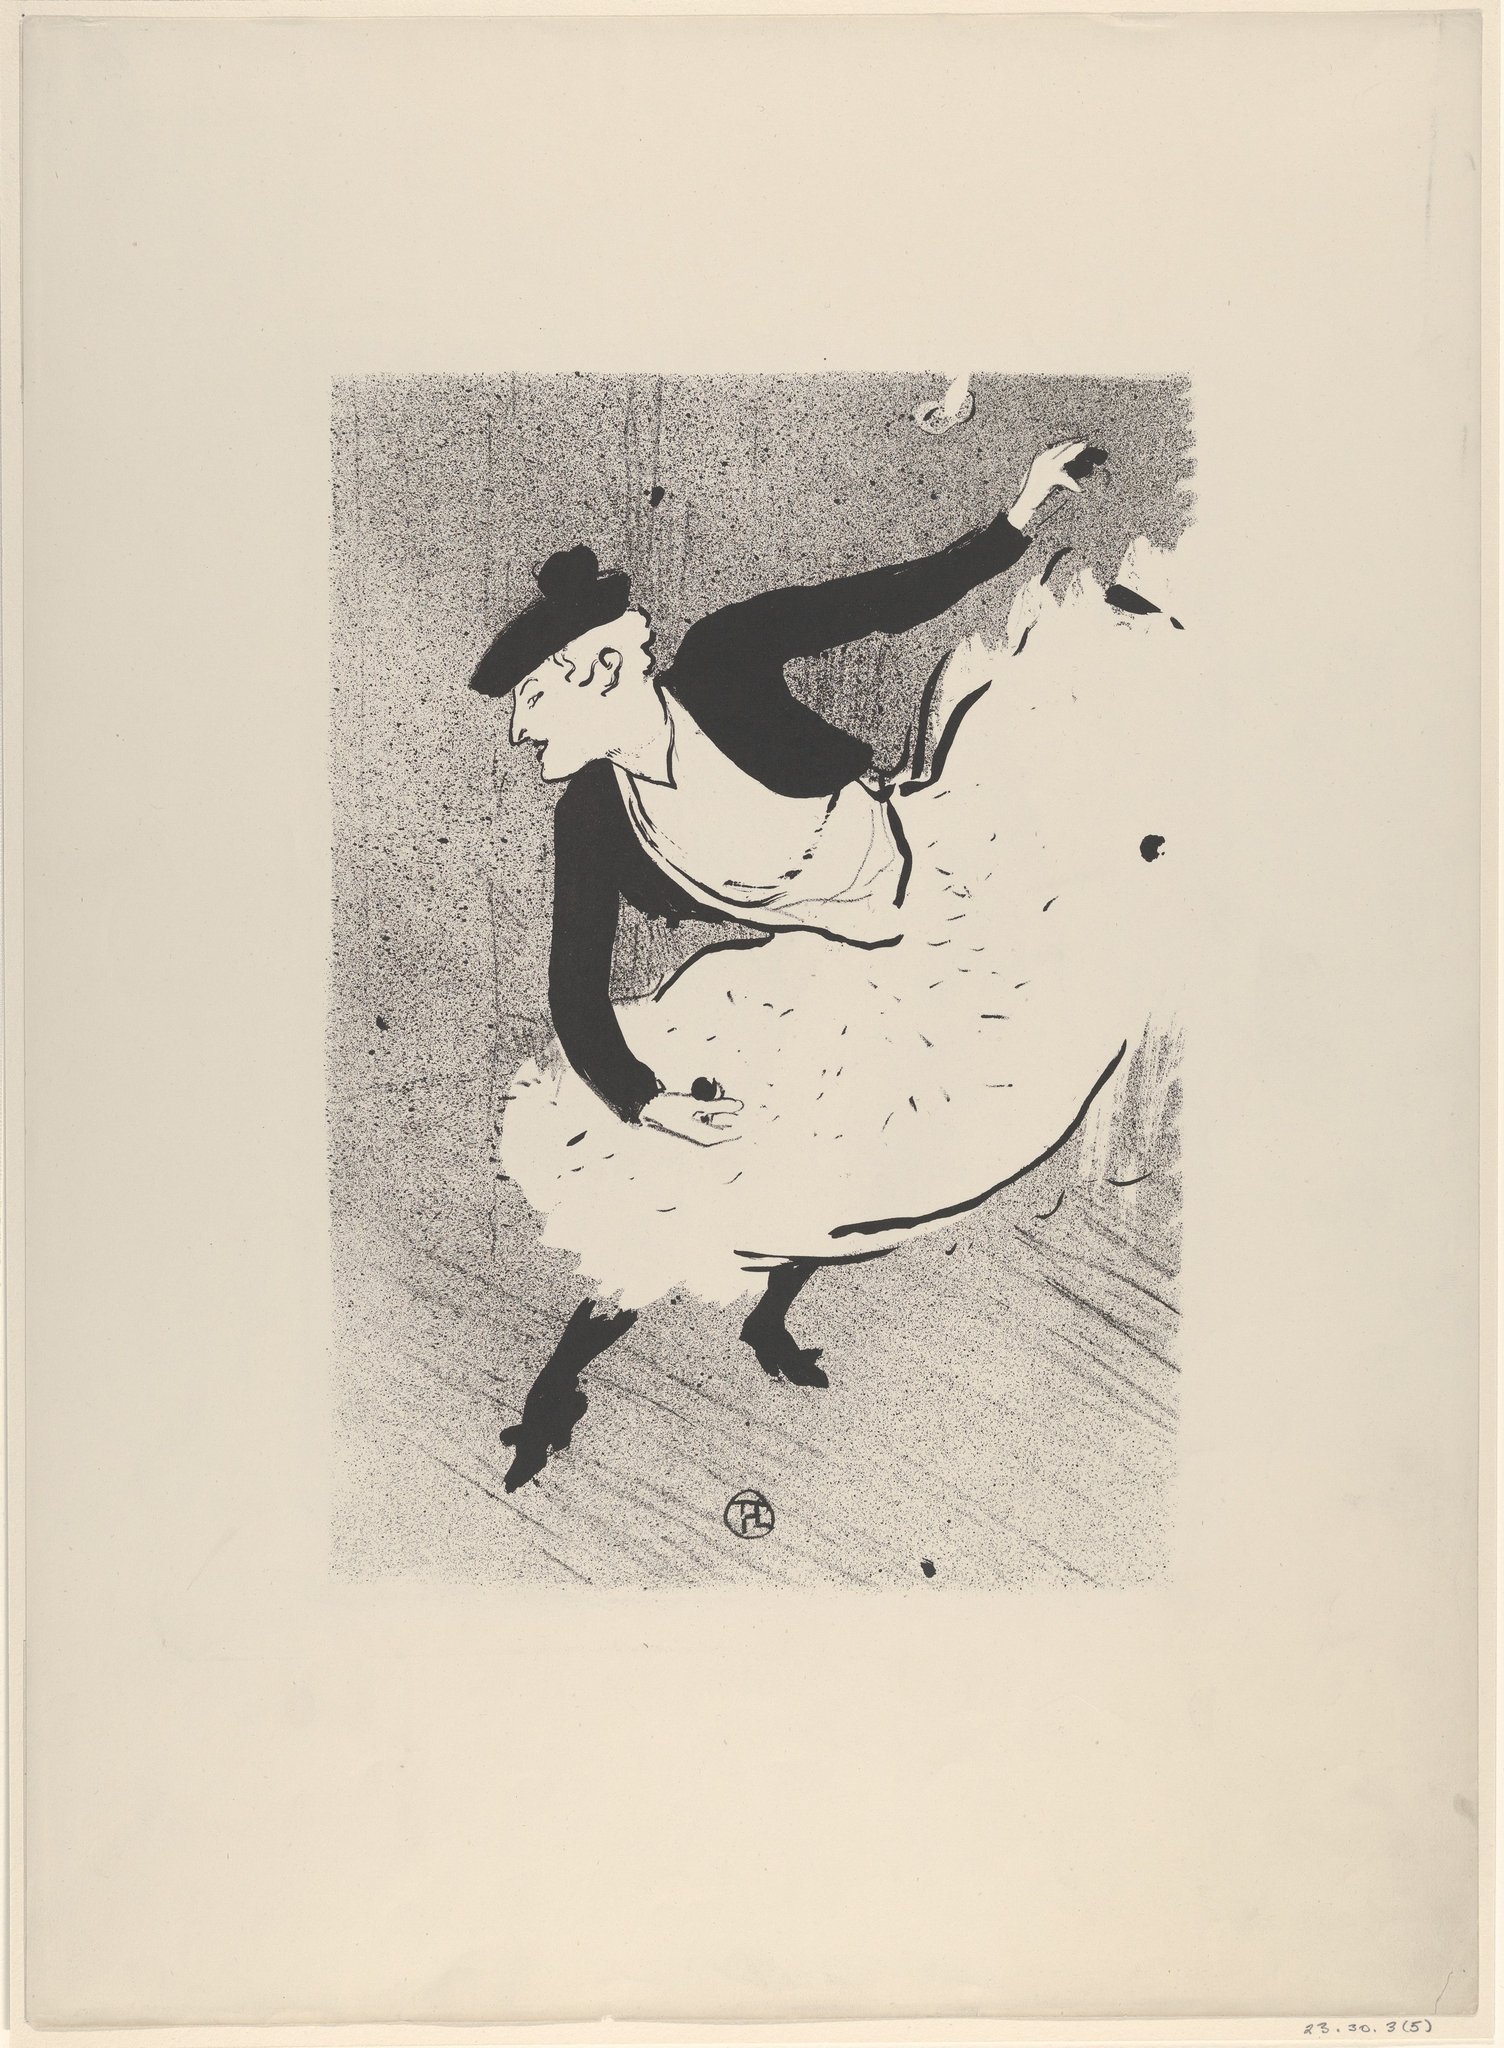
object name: print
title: Edmée Lescot (from Le Café Concert)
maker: henri de toulouse-lautrec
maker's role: artist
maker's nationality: french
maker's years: 1864-1901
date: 1893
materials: crayon, paper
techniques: brush, lithograph, printing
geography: france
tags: women